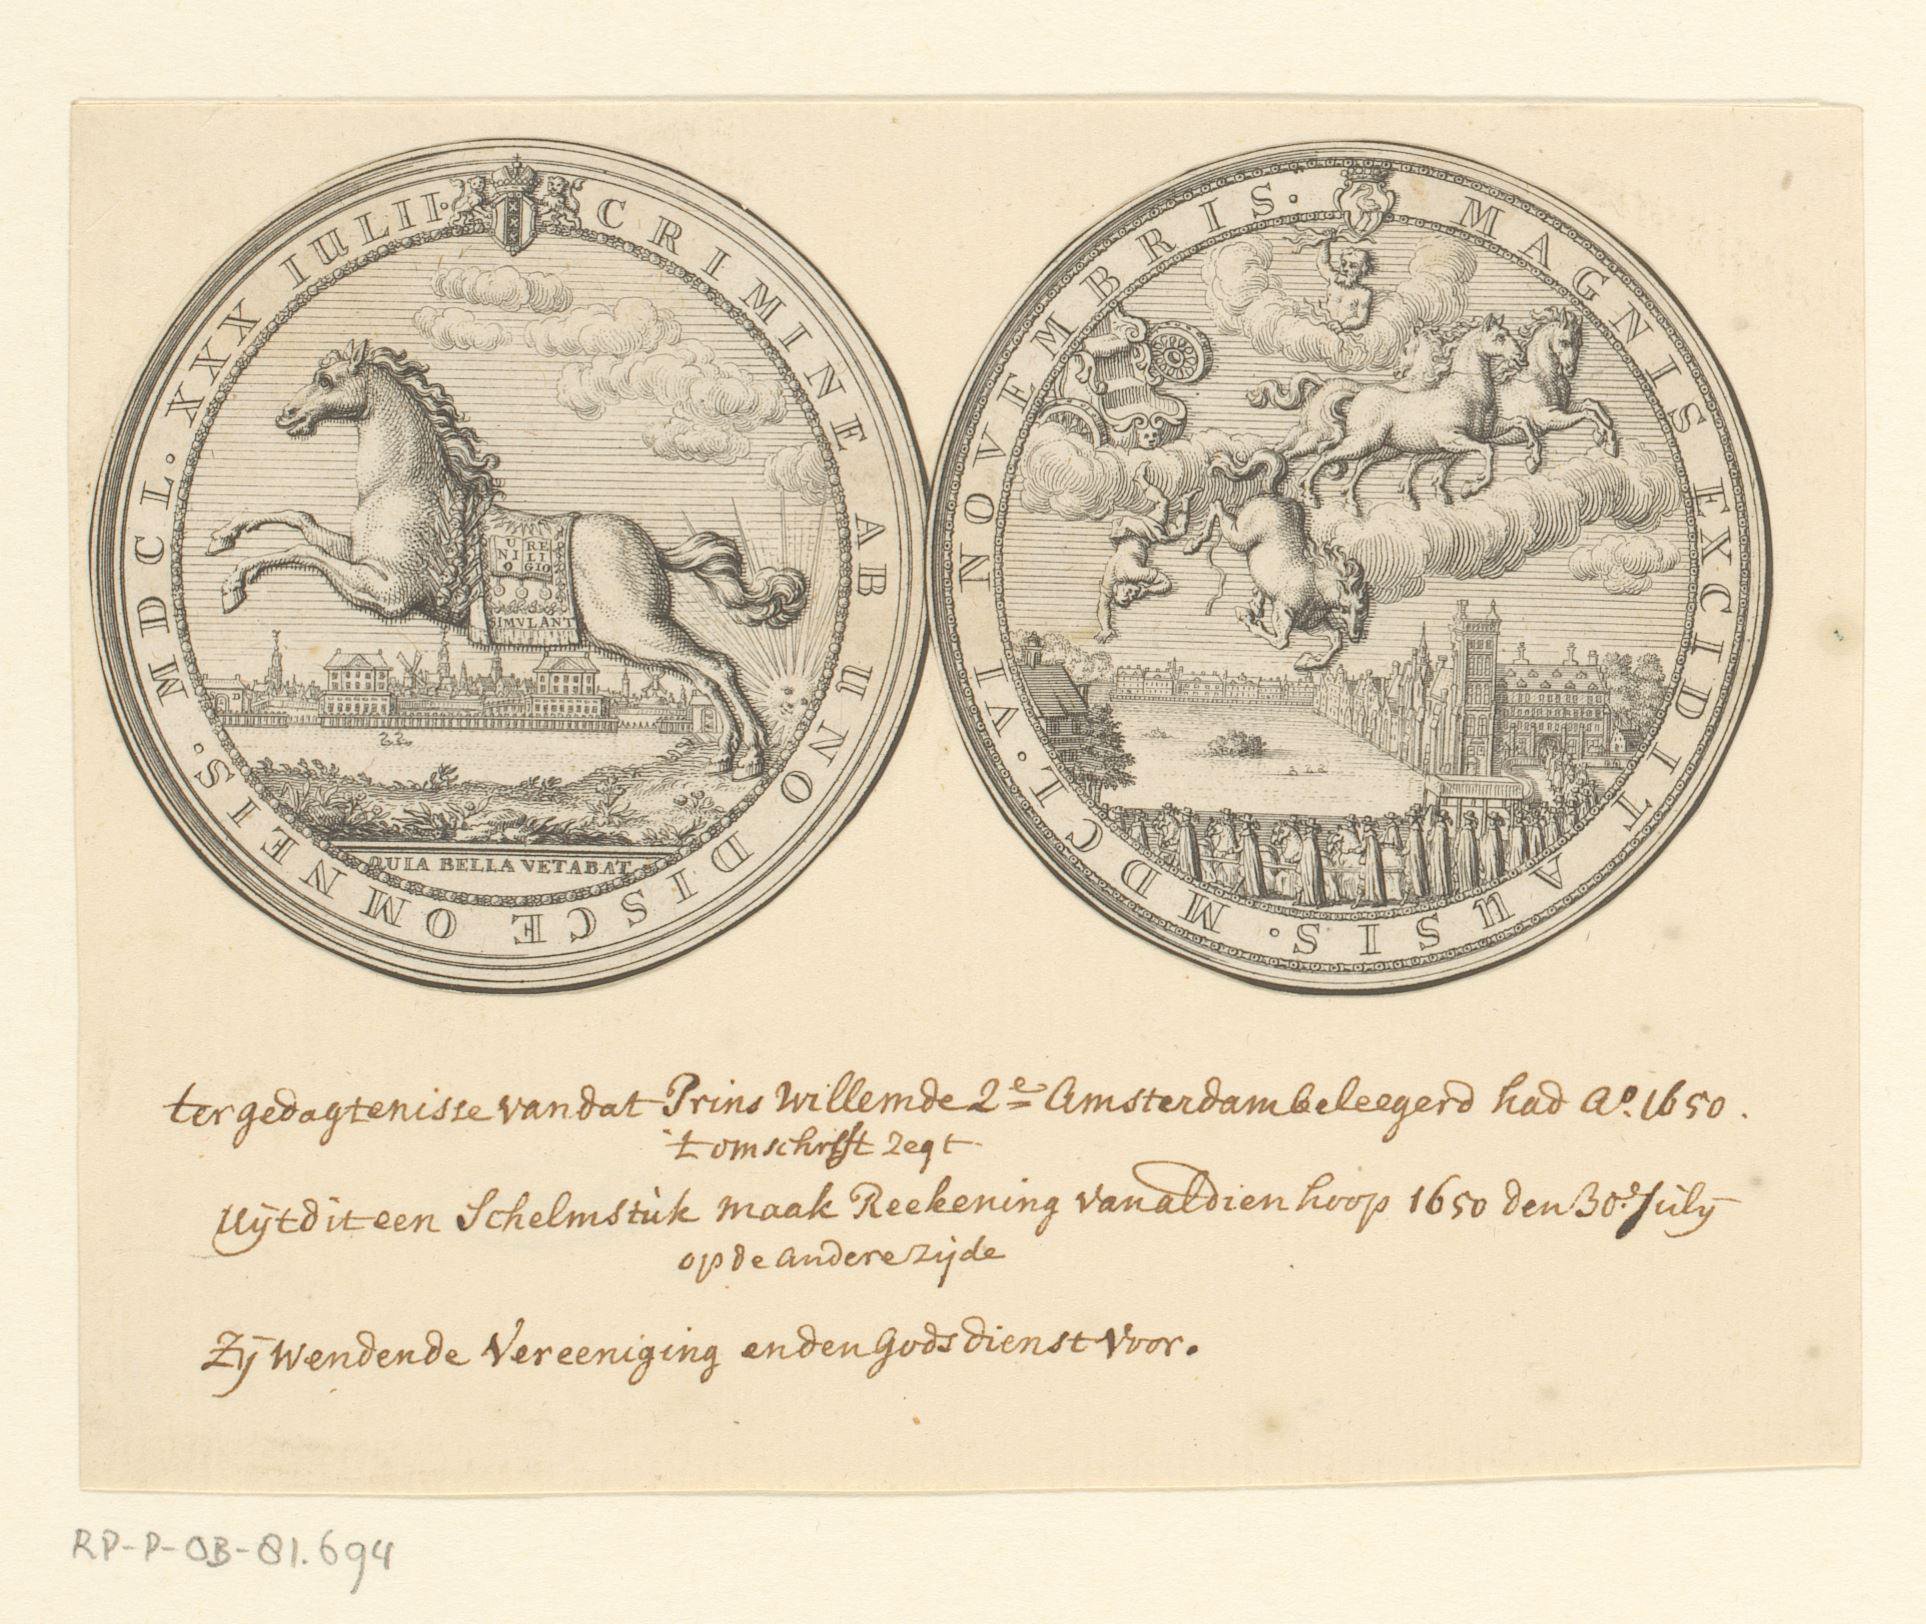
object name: historical object representation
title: Penning op het overlijden van Willem II, 1650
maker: Anonymous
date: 1724-1726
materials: paper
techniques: etching, writing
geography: northern netherlands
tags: william ii (prince of orange), medal (considered as a piece of sculpture, regardless of its specific function), amsterdam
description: Een penning over de mislukte aanslag op Amsterdam door prins Willem II op 30 juli 1650 en de begrafenisstoet van de prins in Den Haag, 8 maart 1651. Voorzijde: rennend paard, met krijgslieden onder dekkleed; op achtergrond gezicht op de blokhuizen aan de Amstel. Keerzijde: de val van Phaëthon, daaronder de lijkstoet bij het Hof in Den Haag. Uitgeknipte en opgeplakte illustraties zonder tekst op achterzijde.